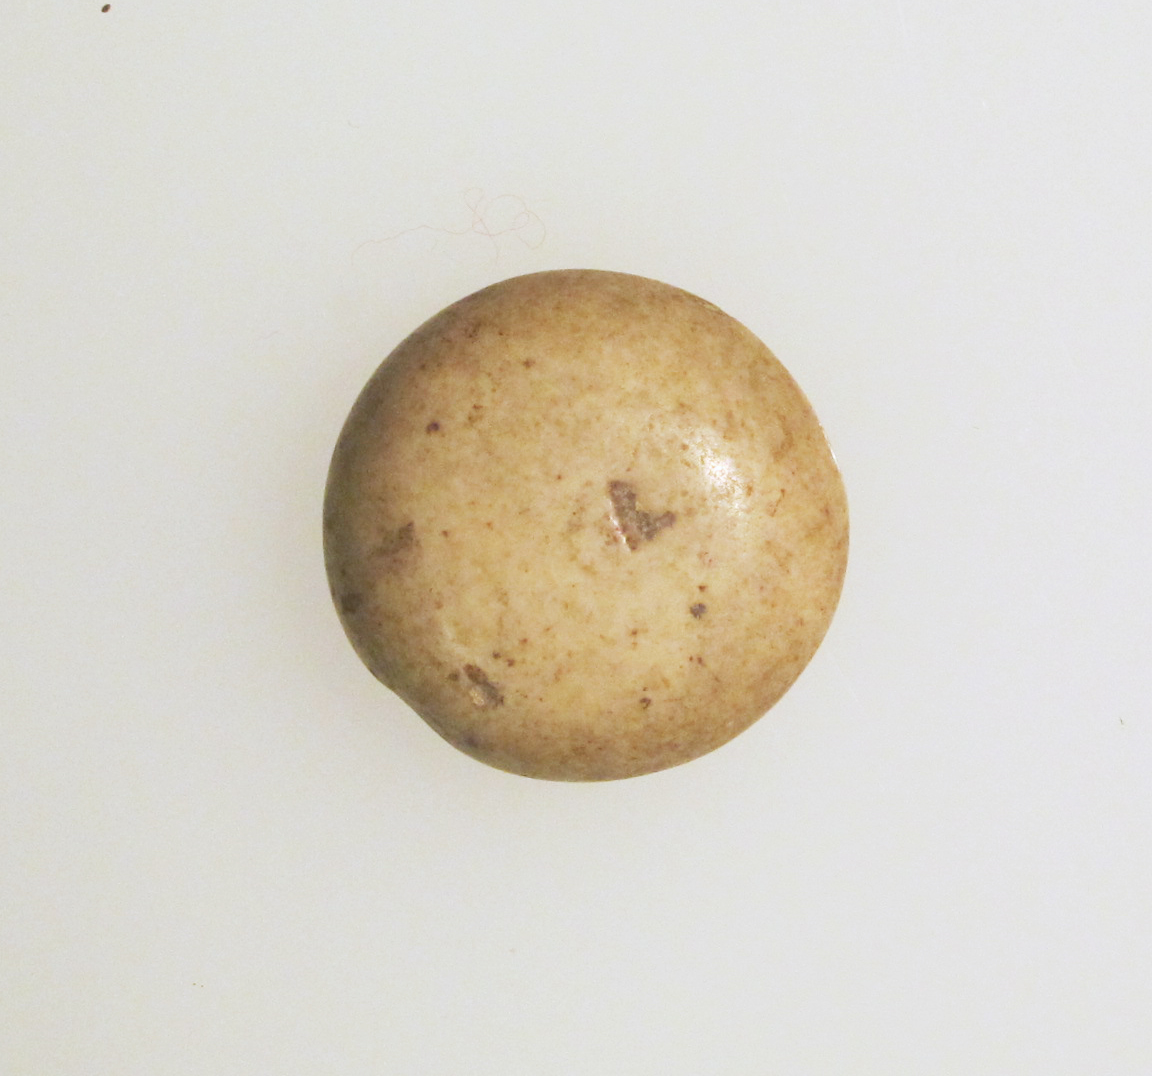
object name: counter or gaming piece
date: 7000 BCE-330 CE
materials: stone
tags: games